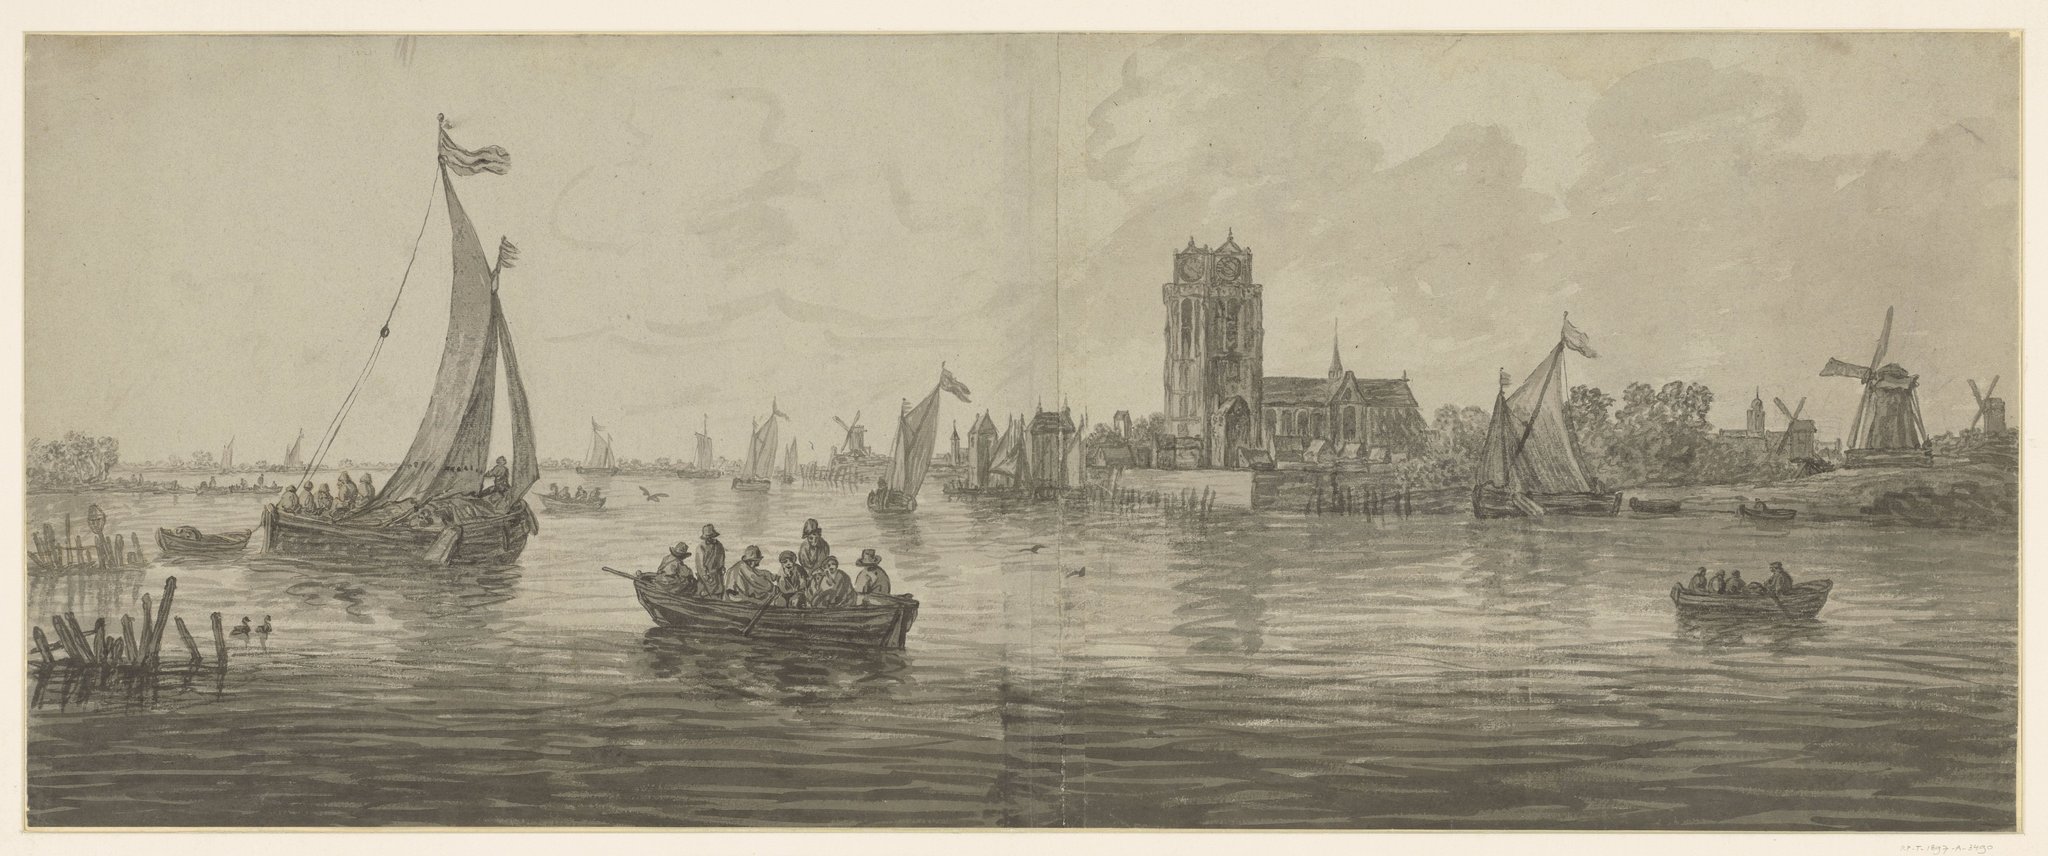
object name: drawing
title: Gezicht op Dordrecht uit het zuid-westen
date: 1766-1815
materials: chalk, ink, paper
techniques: brush, pen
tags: river, church (exterior), prospect of city, town panorama, silhouette of city, dordrecht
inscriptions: inscription: ‘zeilend platboom schip’